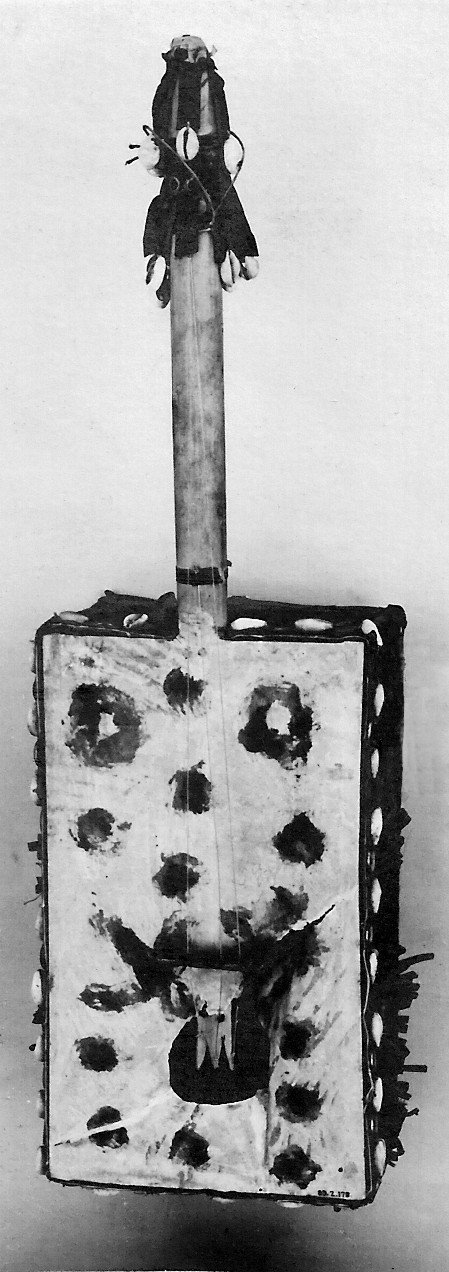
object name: rebab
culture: moroccan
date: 1867-1900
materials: parchment, wood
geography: morocco